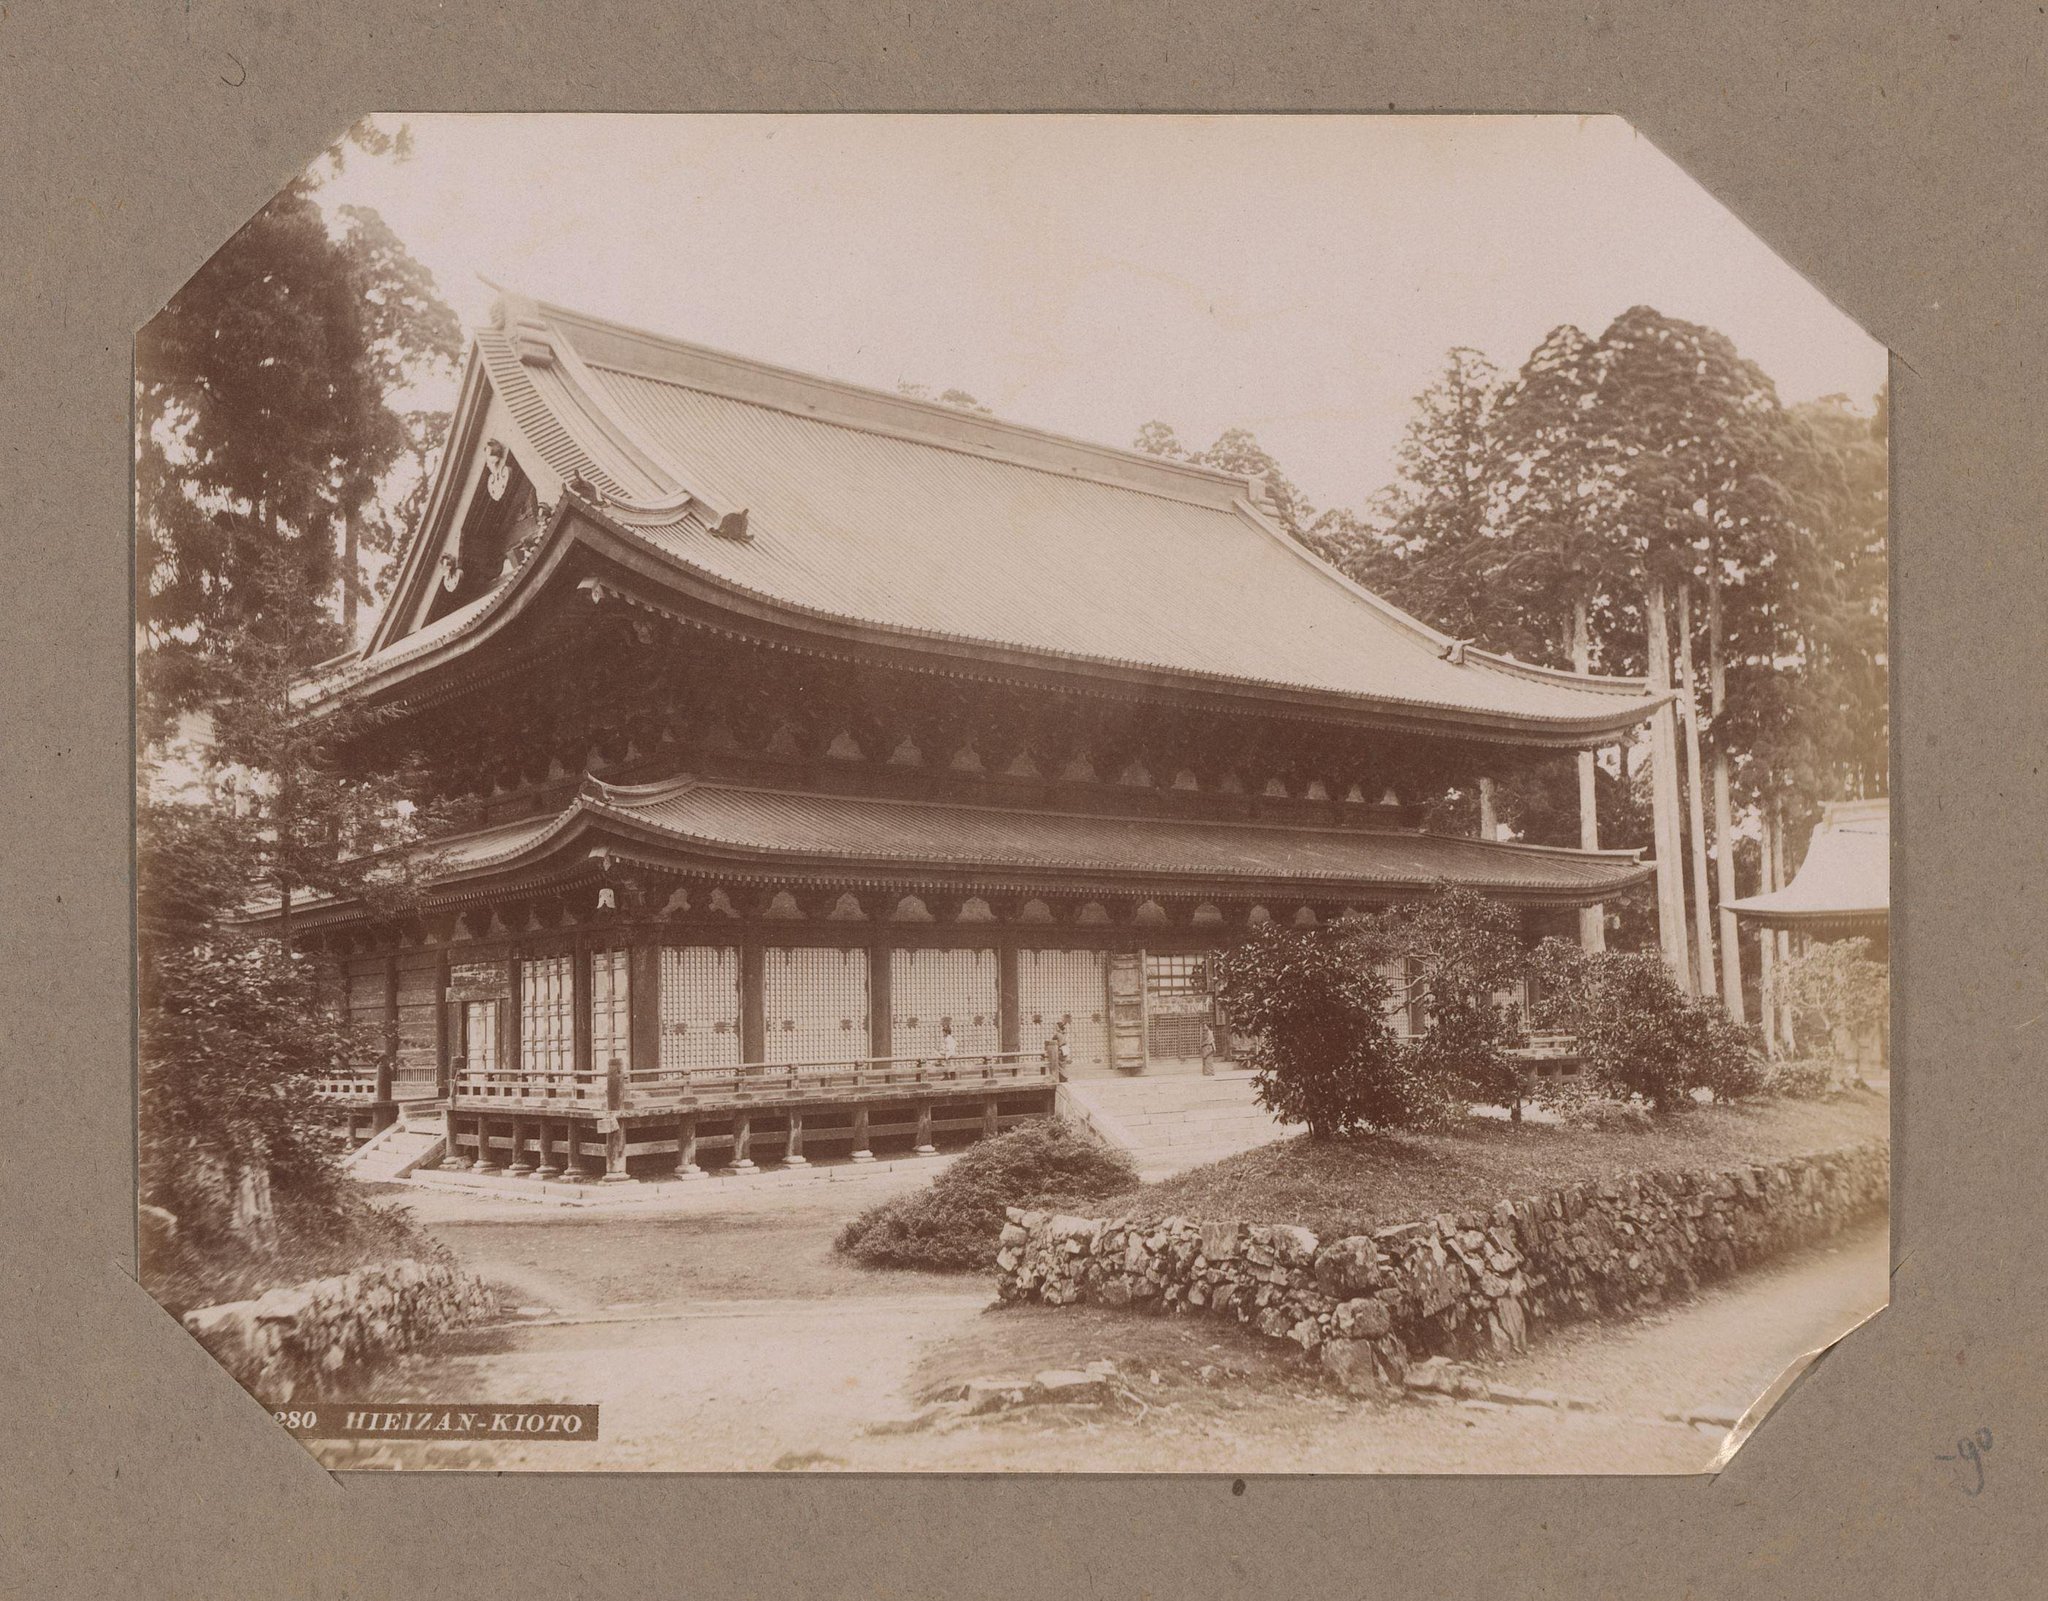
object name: album leaf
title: Gezicht op een gebouw van het Enryaku-ji tempelcomplex op de berg Hiei bij Kyoto, Japan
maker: Anonymous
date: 1890-1903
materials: paper, photographic support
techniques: albumen print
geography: kyoto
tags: temple, shrine ~ hinduism, buddhism, jainism, kyoto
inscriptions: inscription: ‘280 Hieizan-Kioto’